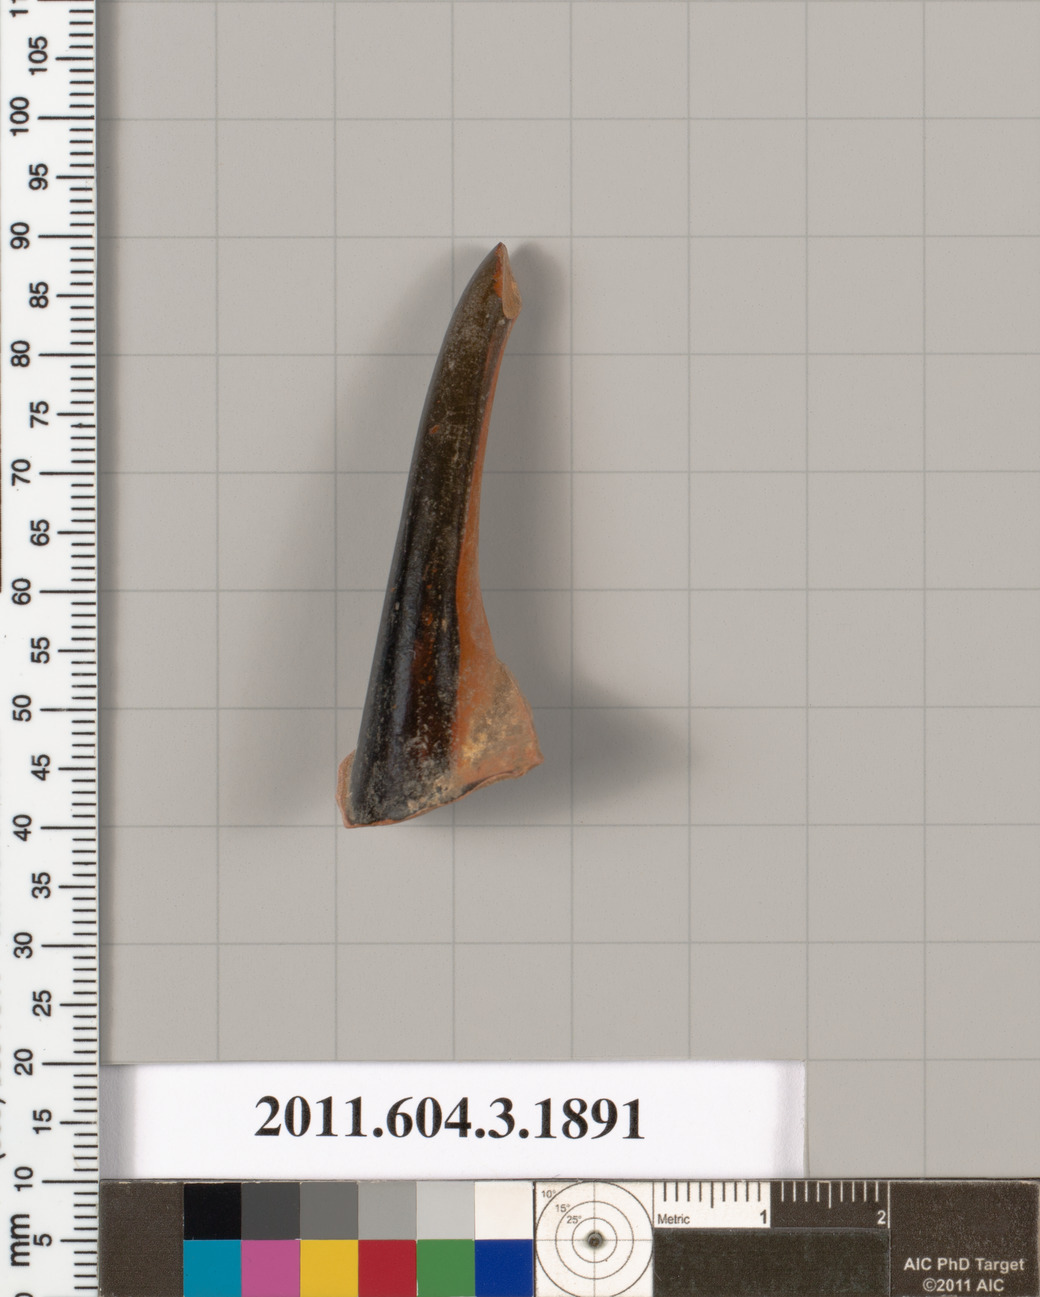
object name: kylix or skyphos fragment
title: Terracotta fragment of a kylix (drinking cup) or a skyphos (deep drinking cup)?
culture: greek, attic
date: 600-401 BCE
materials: terracotta